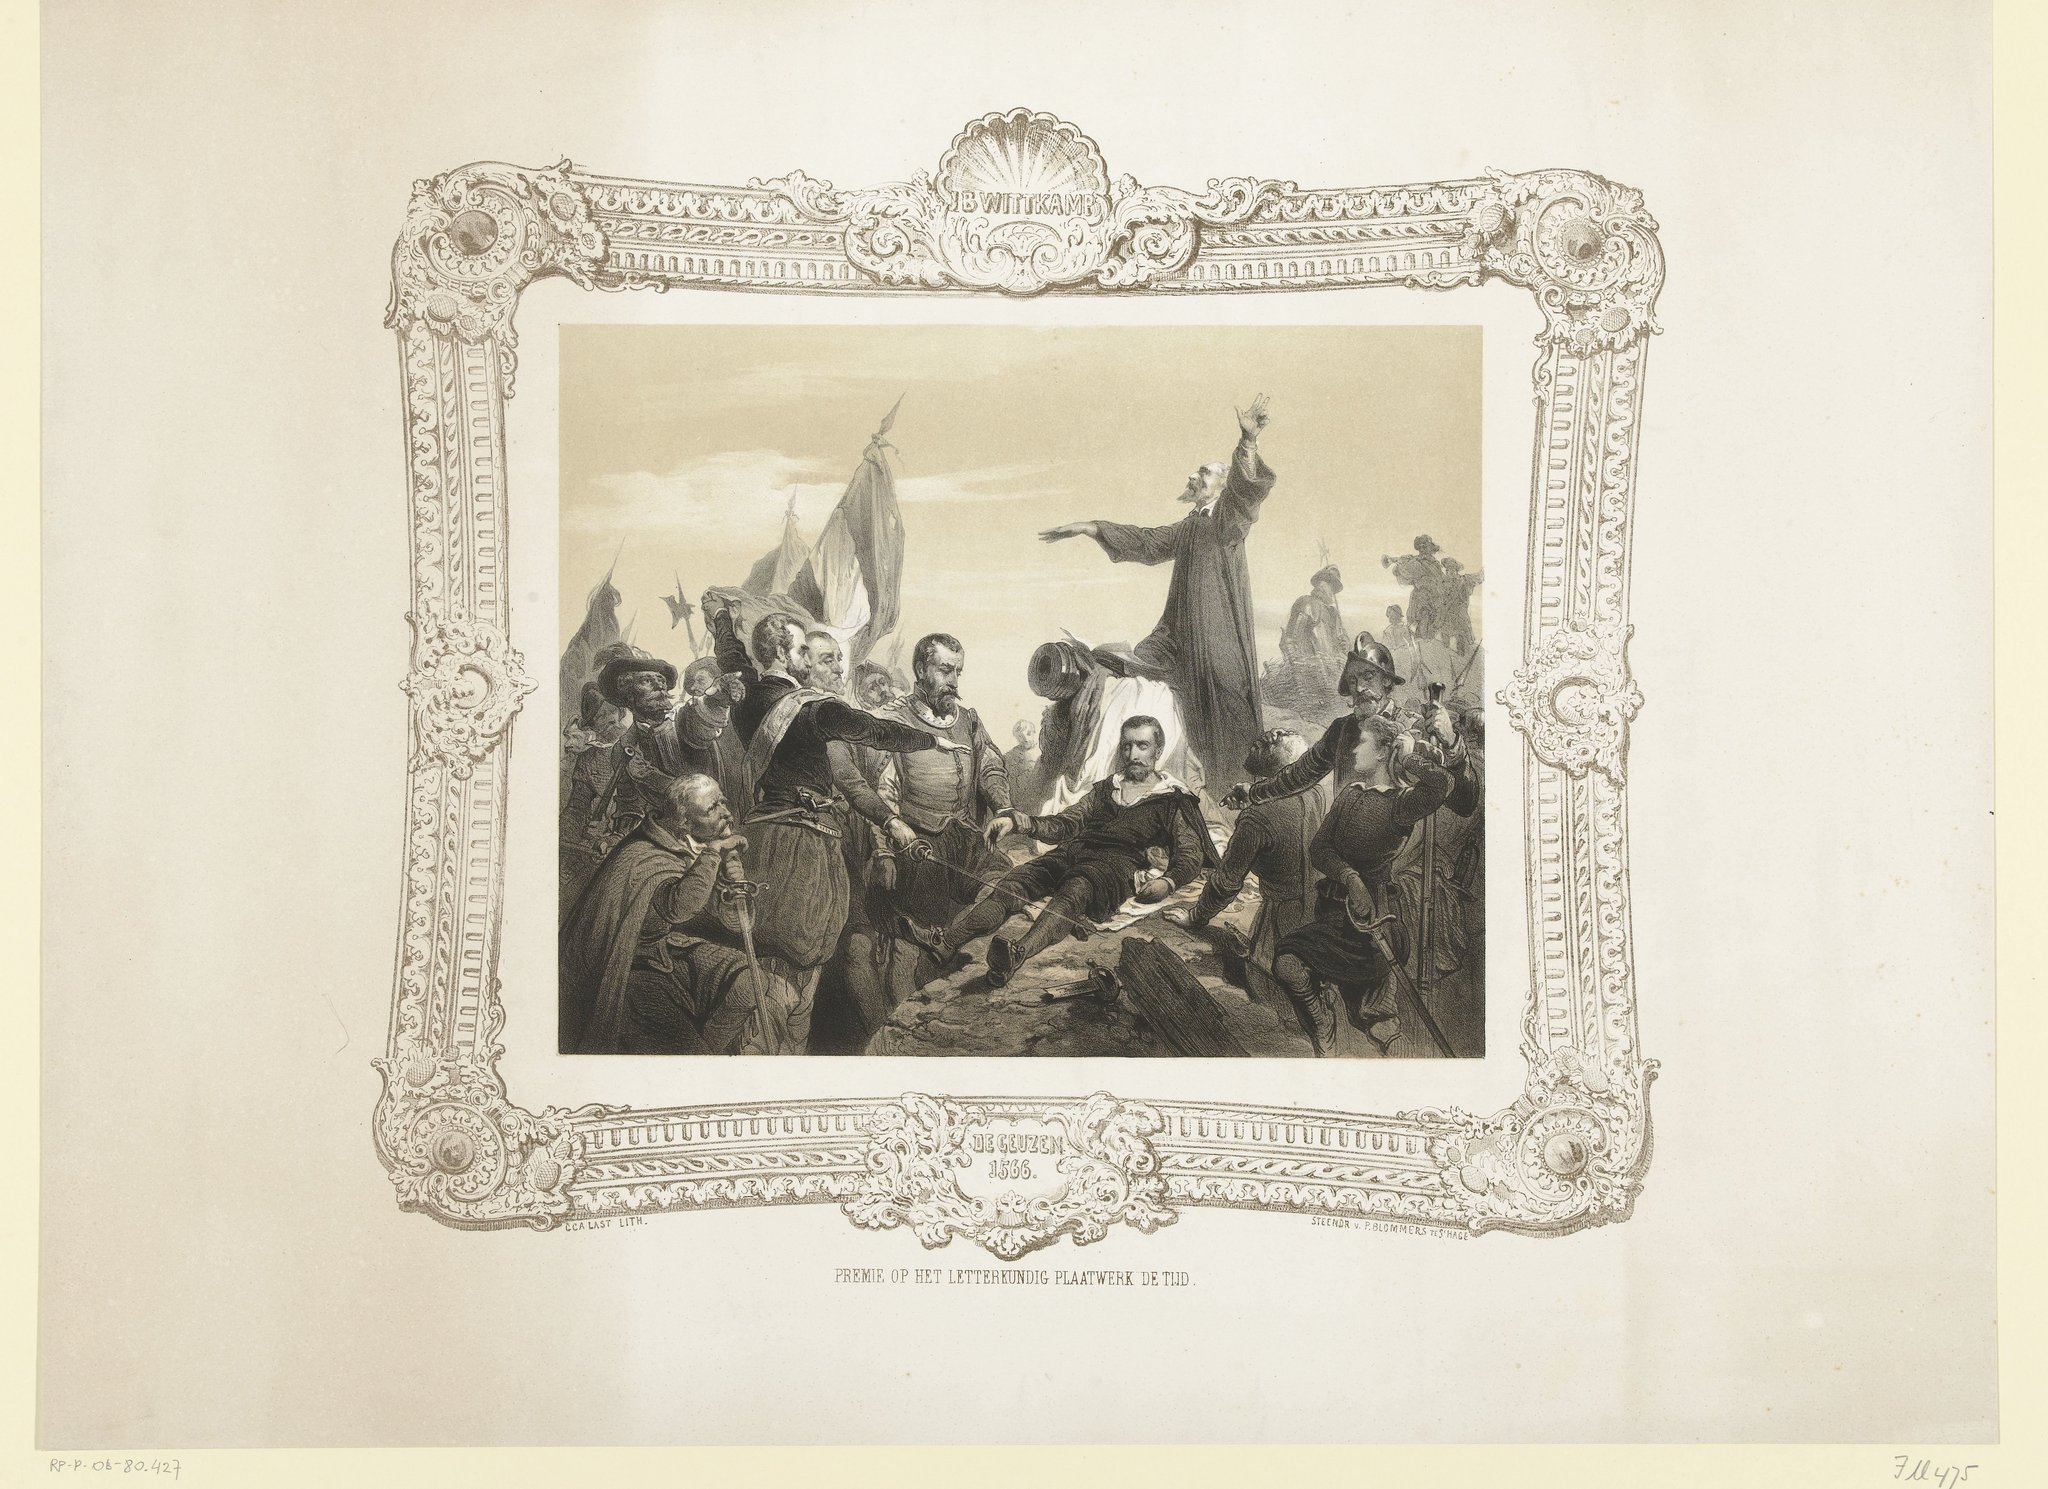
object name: print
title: De Geuzen, 1566.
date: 1830-1876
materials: paper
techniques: tone lithography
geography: the hague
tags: battle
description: Geuzen in de strijd tegen de onderdrukking, 1566. Mannen verzameld rond het lichaam van een in de strijd gesneuvelde man. Een prediker roept staande op bijbel en kanon op tot de strijd.